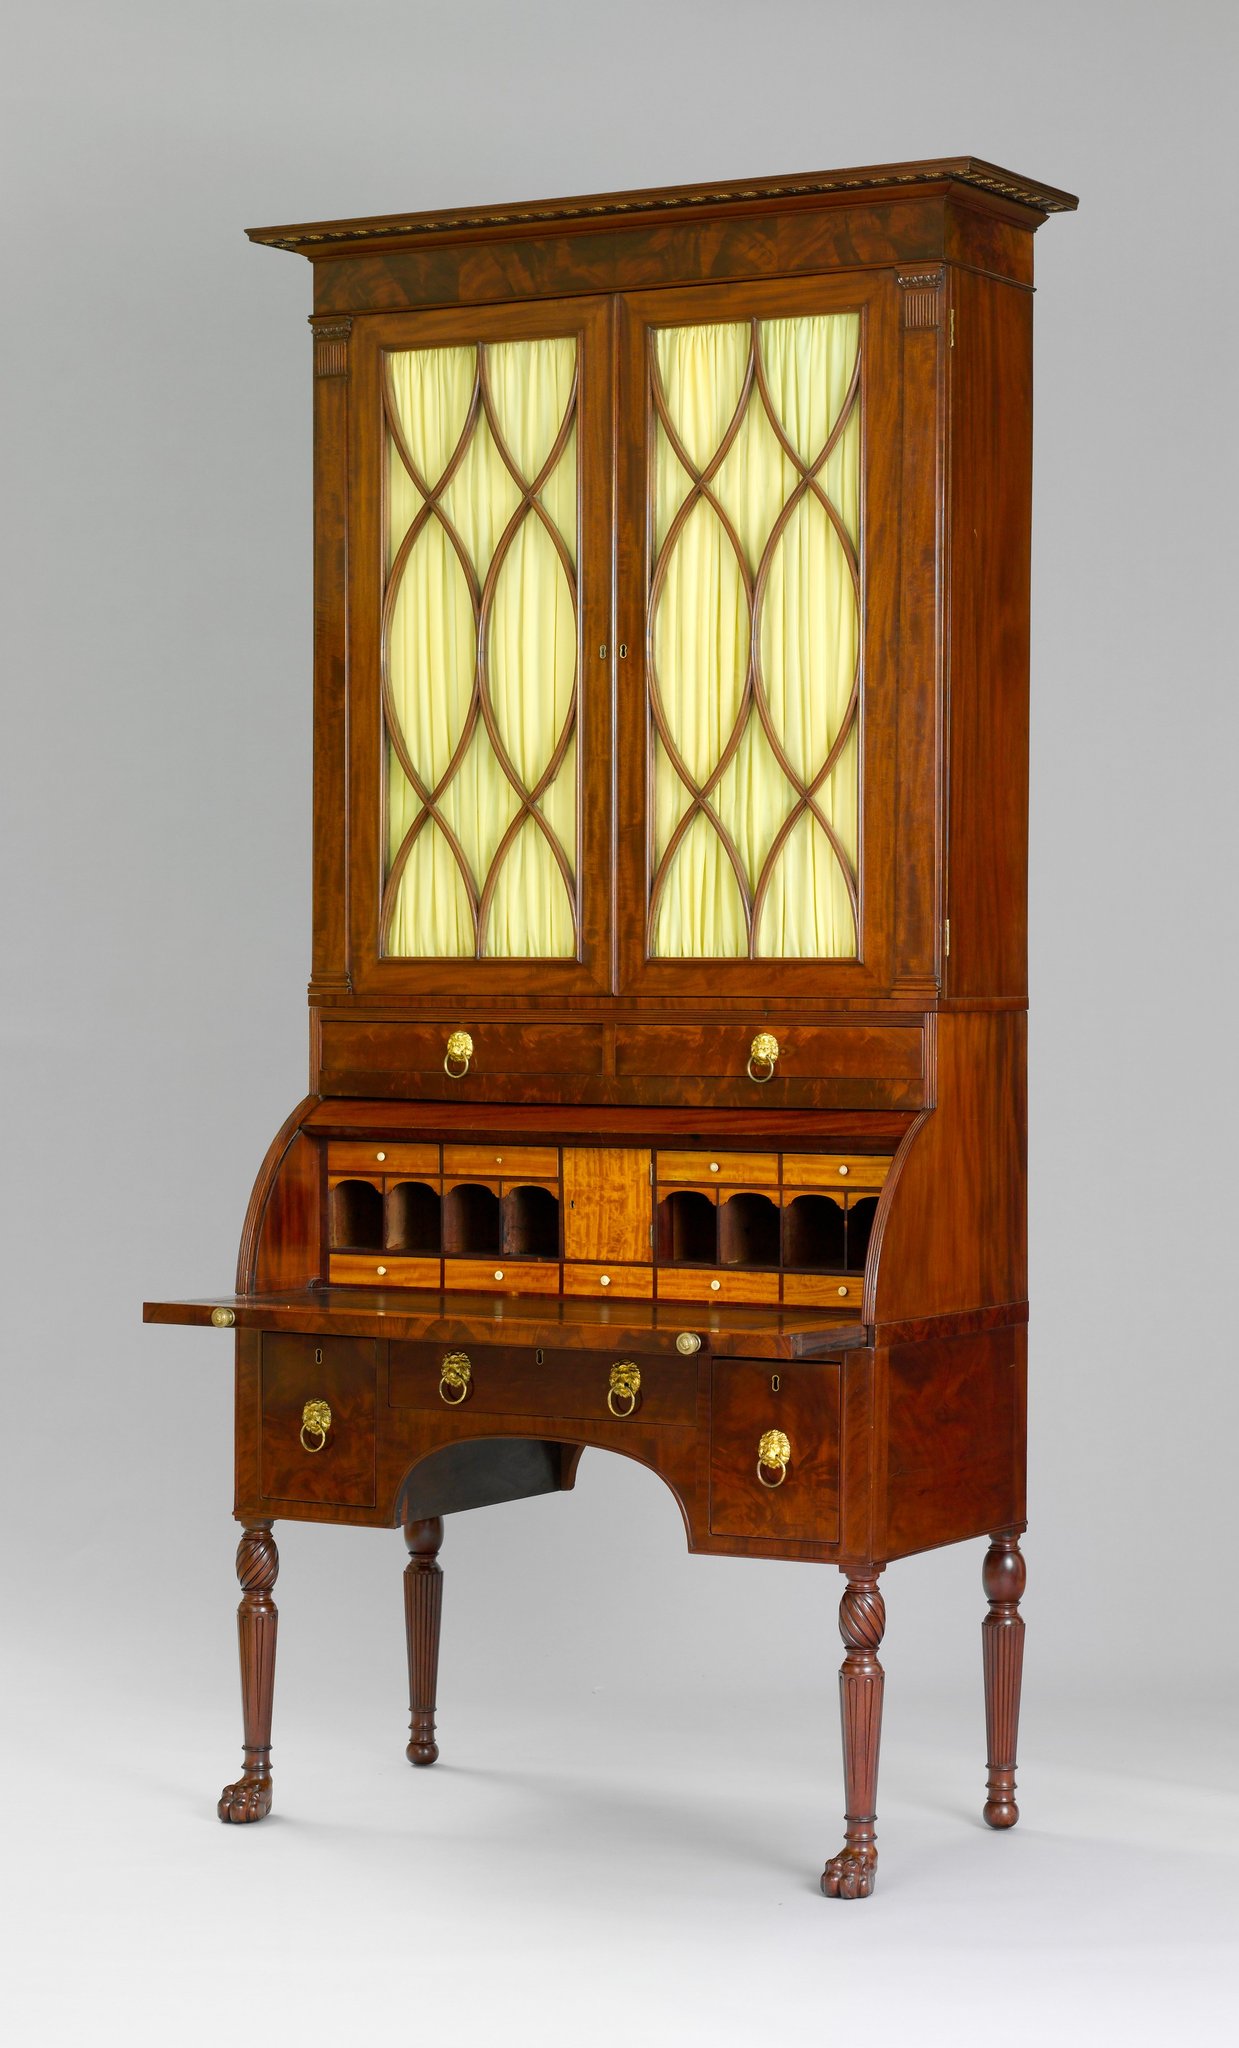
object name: desk and bookcase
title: Cylinder Desk and Bookcase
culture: american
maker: duncan phyfe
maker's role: maker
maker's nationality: american, born scotland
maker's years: 1770-1854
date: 1815-1820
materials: gesso, wood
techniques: gilding, veneering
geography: united states